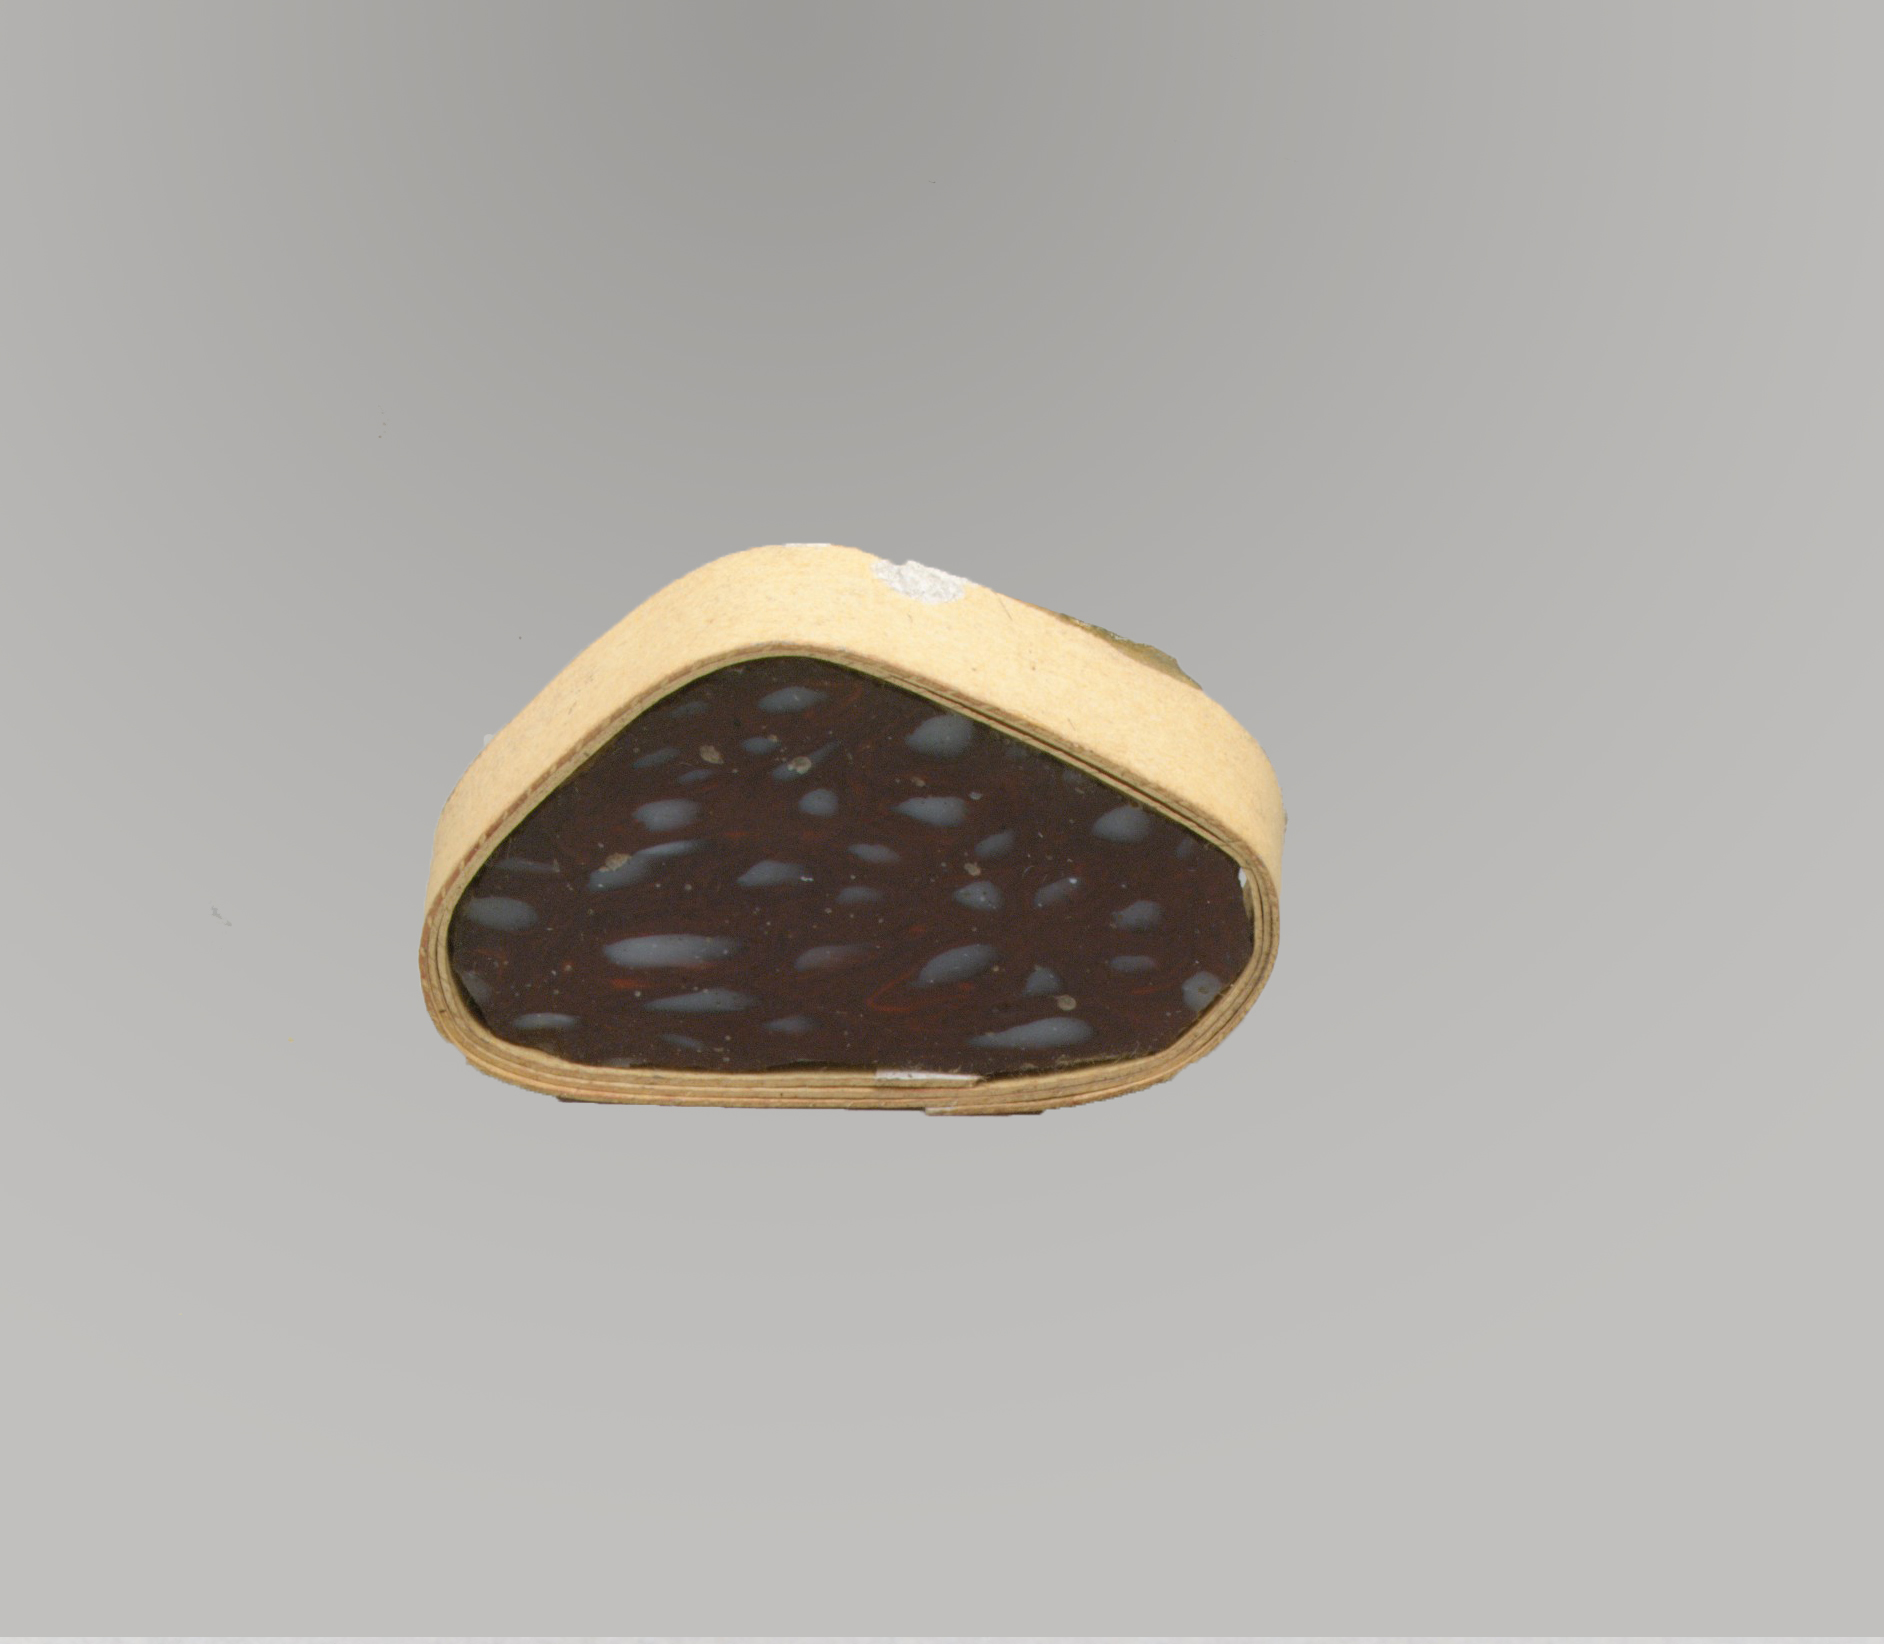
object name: fragment, mosaic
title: Glass mosaic inlay fragment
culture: roman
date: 34 BCE-33 CE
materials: glass